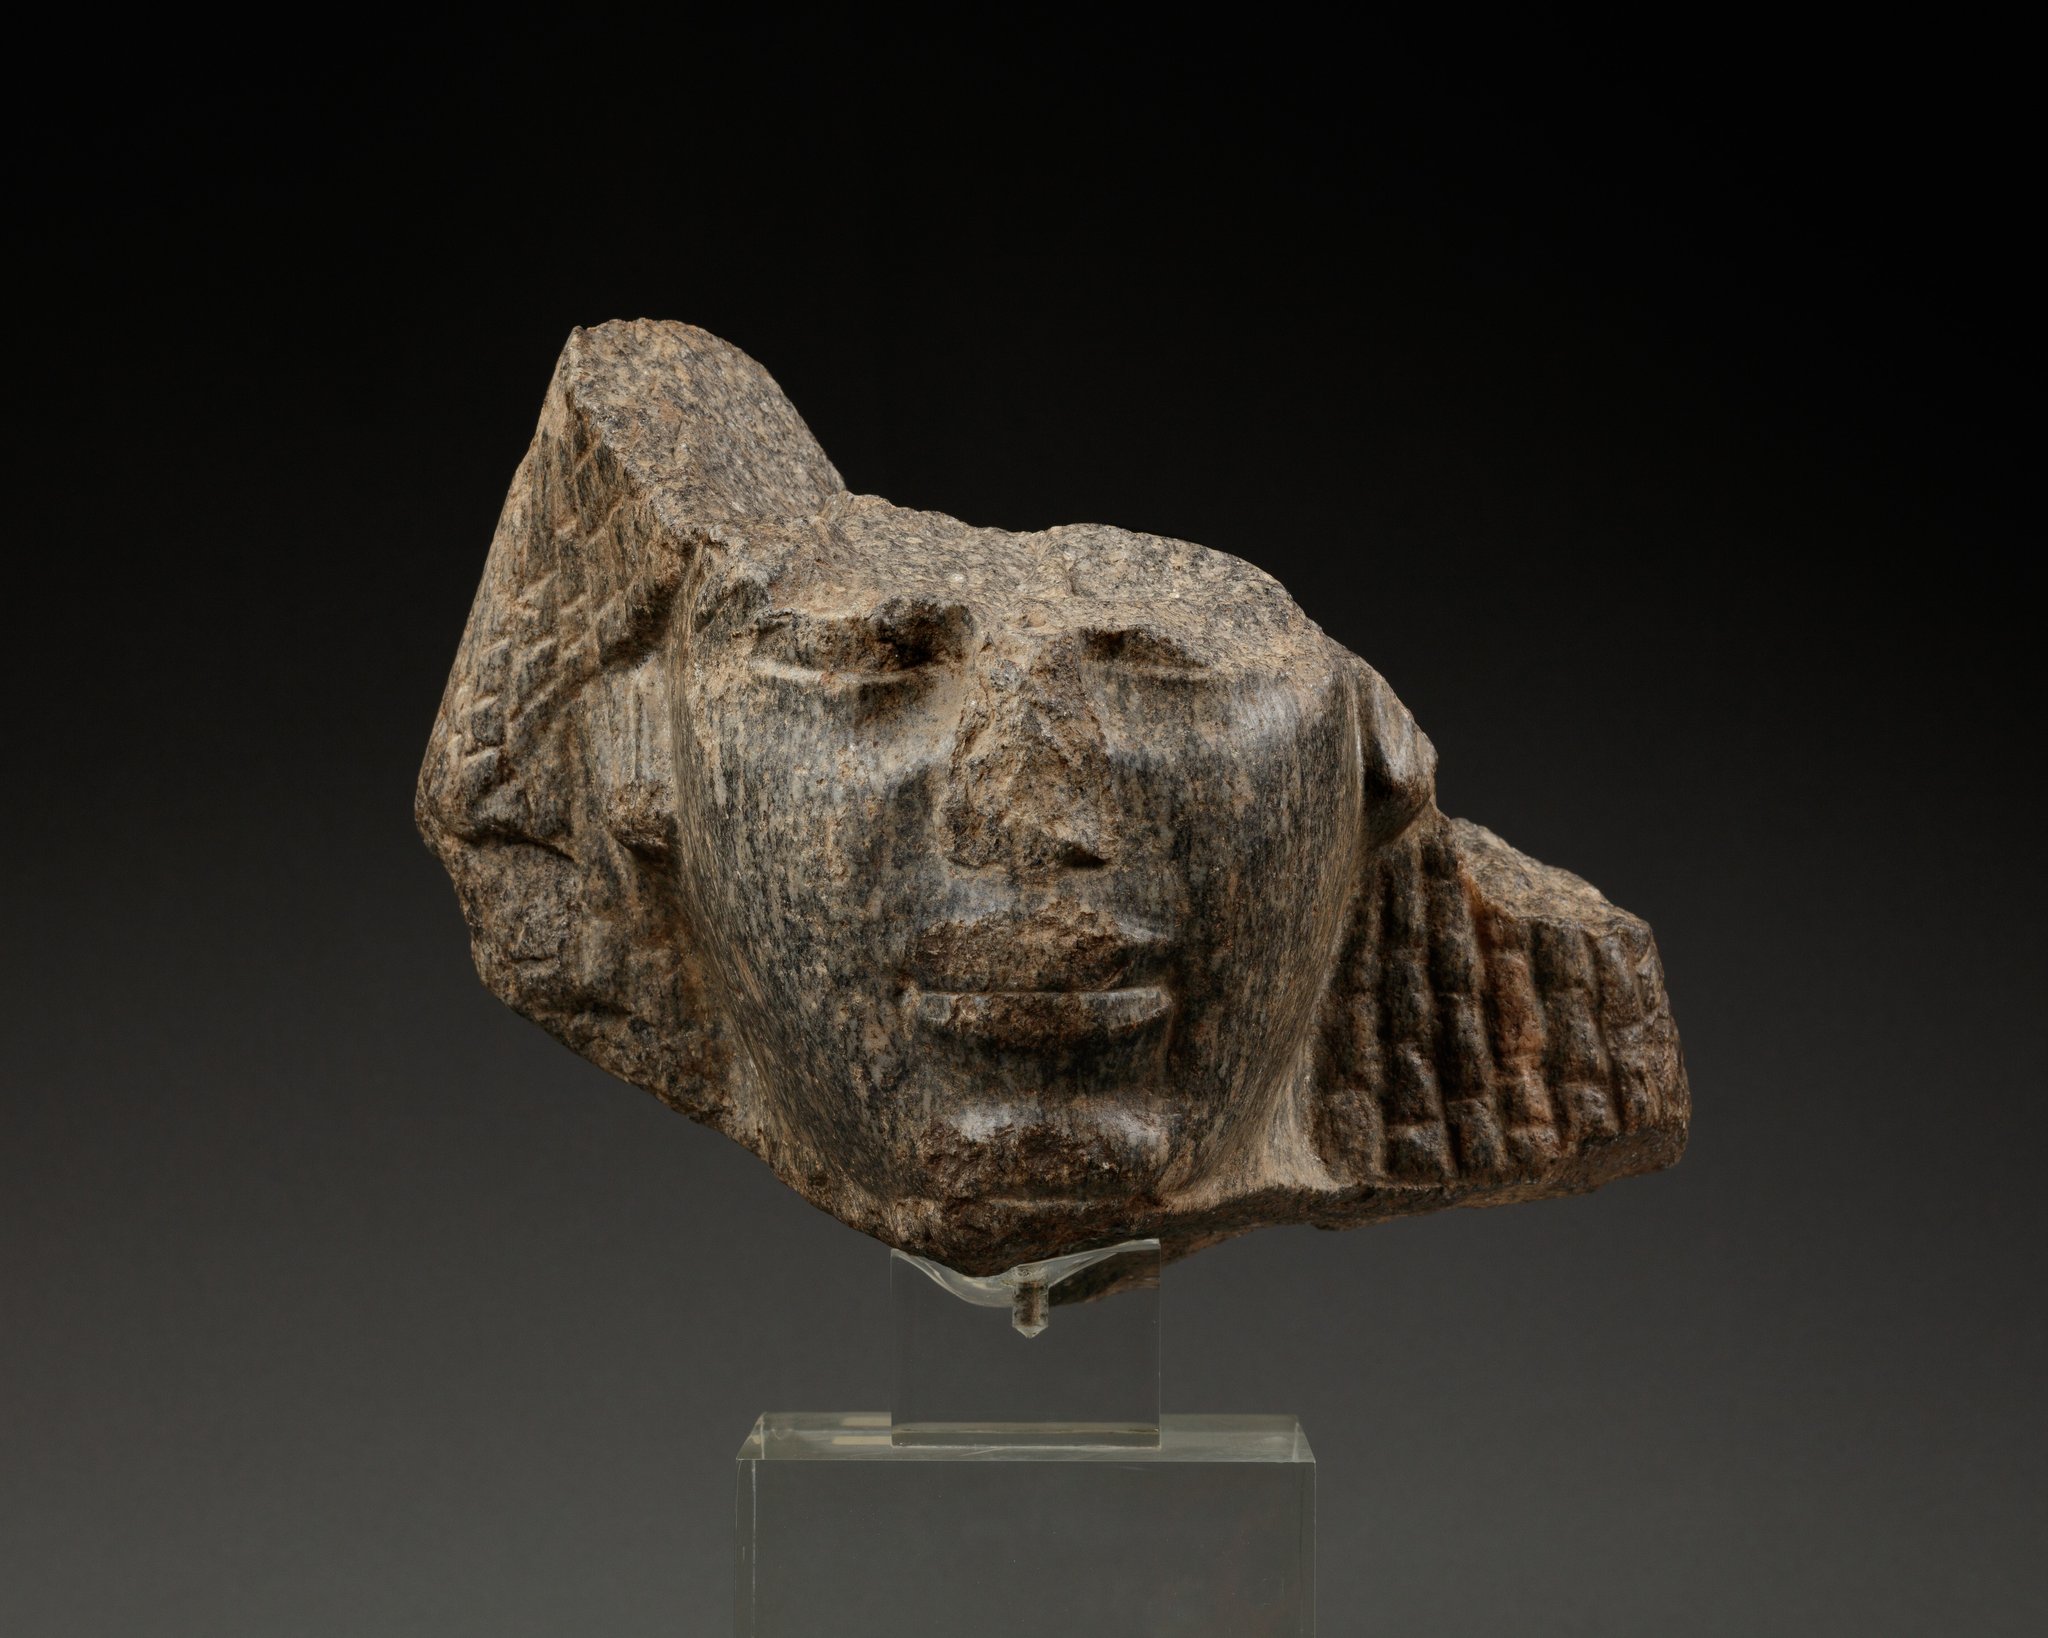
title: Fragmentary Head of a Man, Belonging to a Block Statue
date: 1550-1070 BCE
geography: egypt